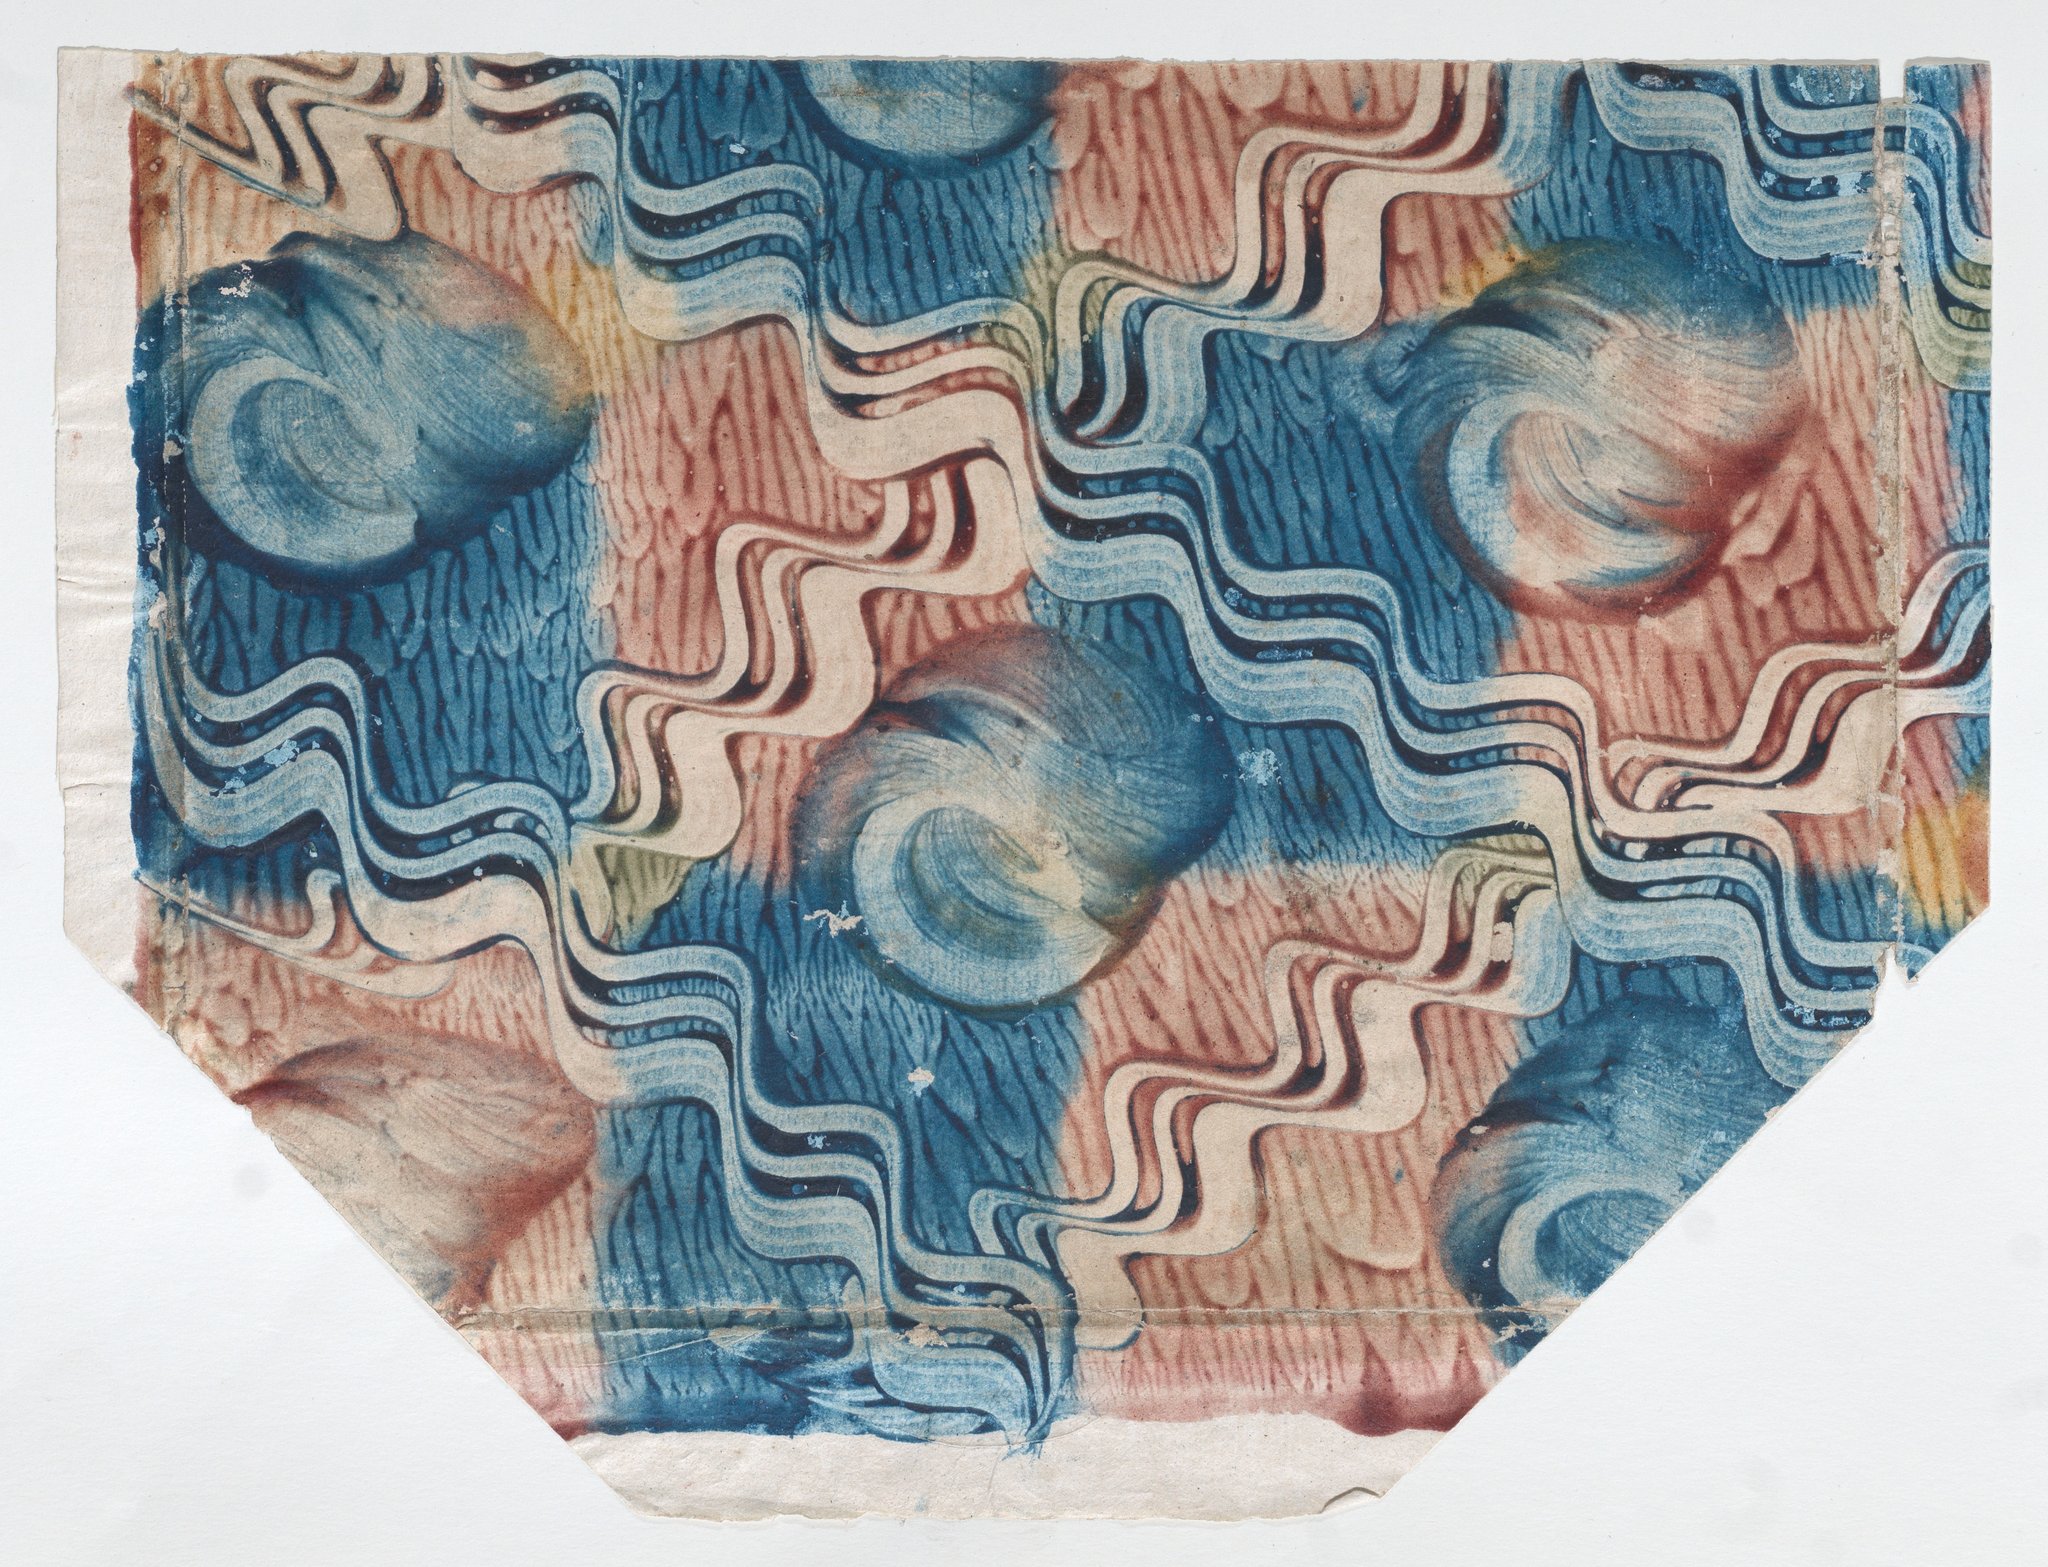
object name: print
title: Blue and pink paste paper with circle and wavy line pattern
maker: Anonymous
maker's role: artist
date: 1801-1900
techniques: relief print